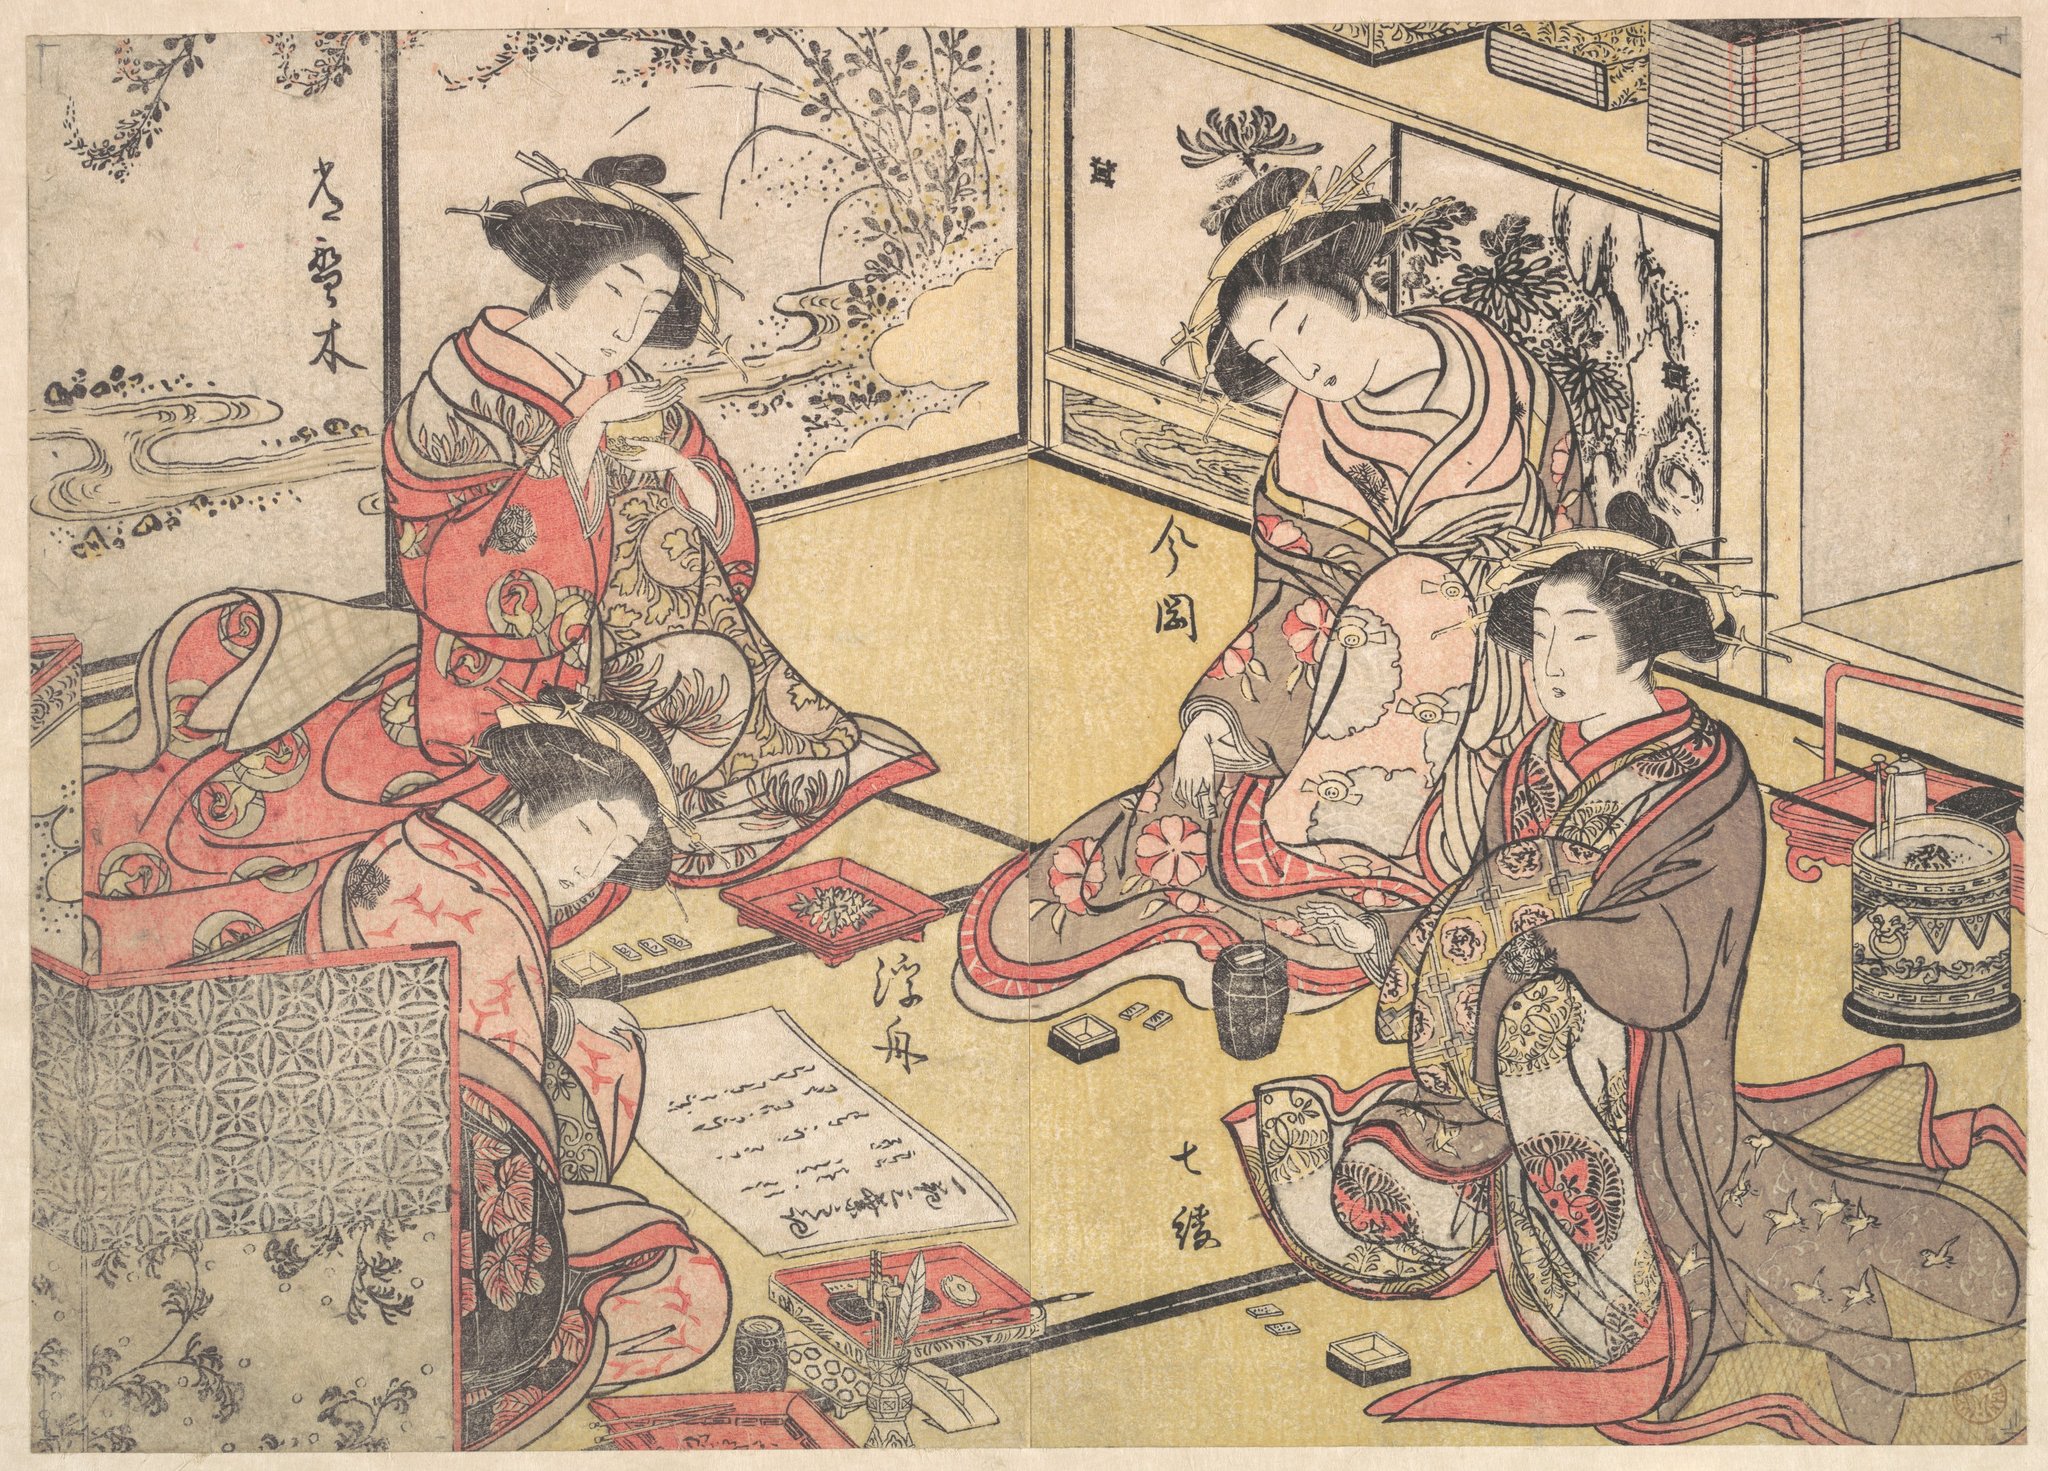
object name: woodblock print nishiki e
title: Four Oiran of the House Called Kadokana-ya Playing the Game of Ko-awase (Incense Game)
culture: japanese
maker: katsukawa shunshō 勝川春章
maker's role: artist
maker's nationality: japanese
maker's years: 1726-1792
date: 1776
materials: ink, paper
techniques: nishiki e, woodblock print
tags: women,playing